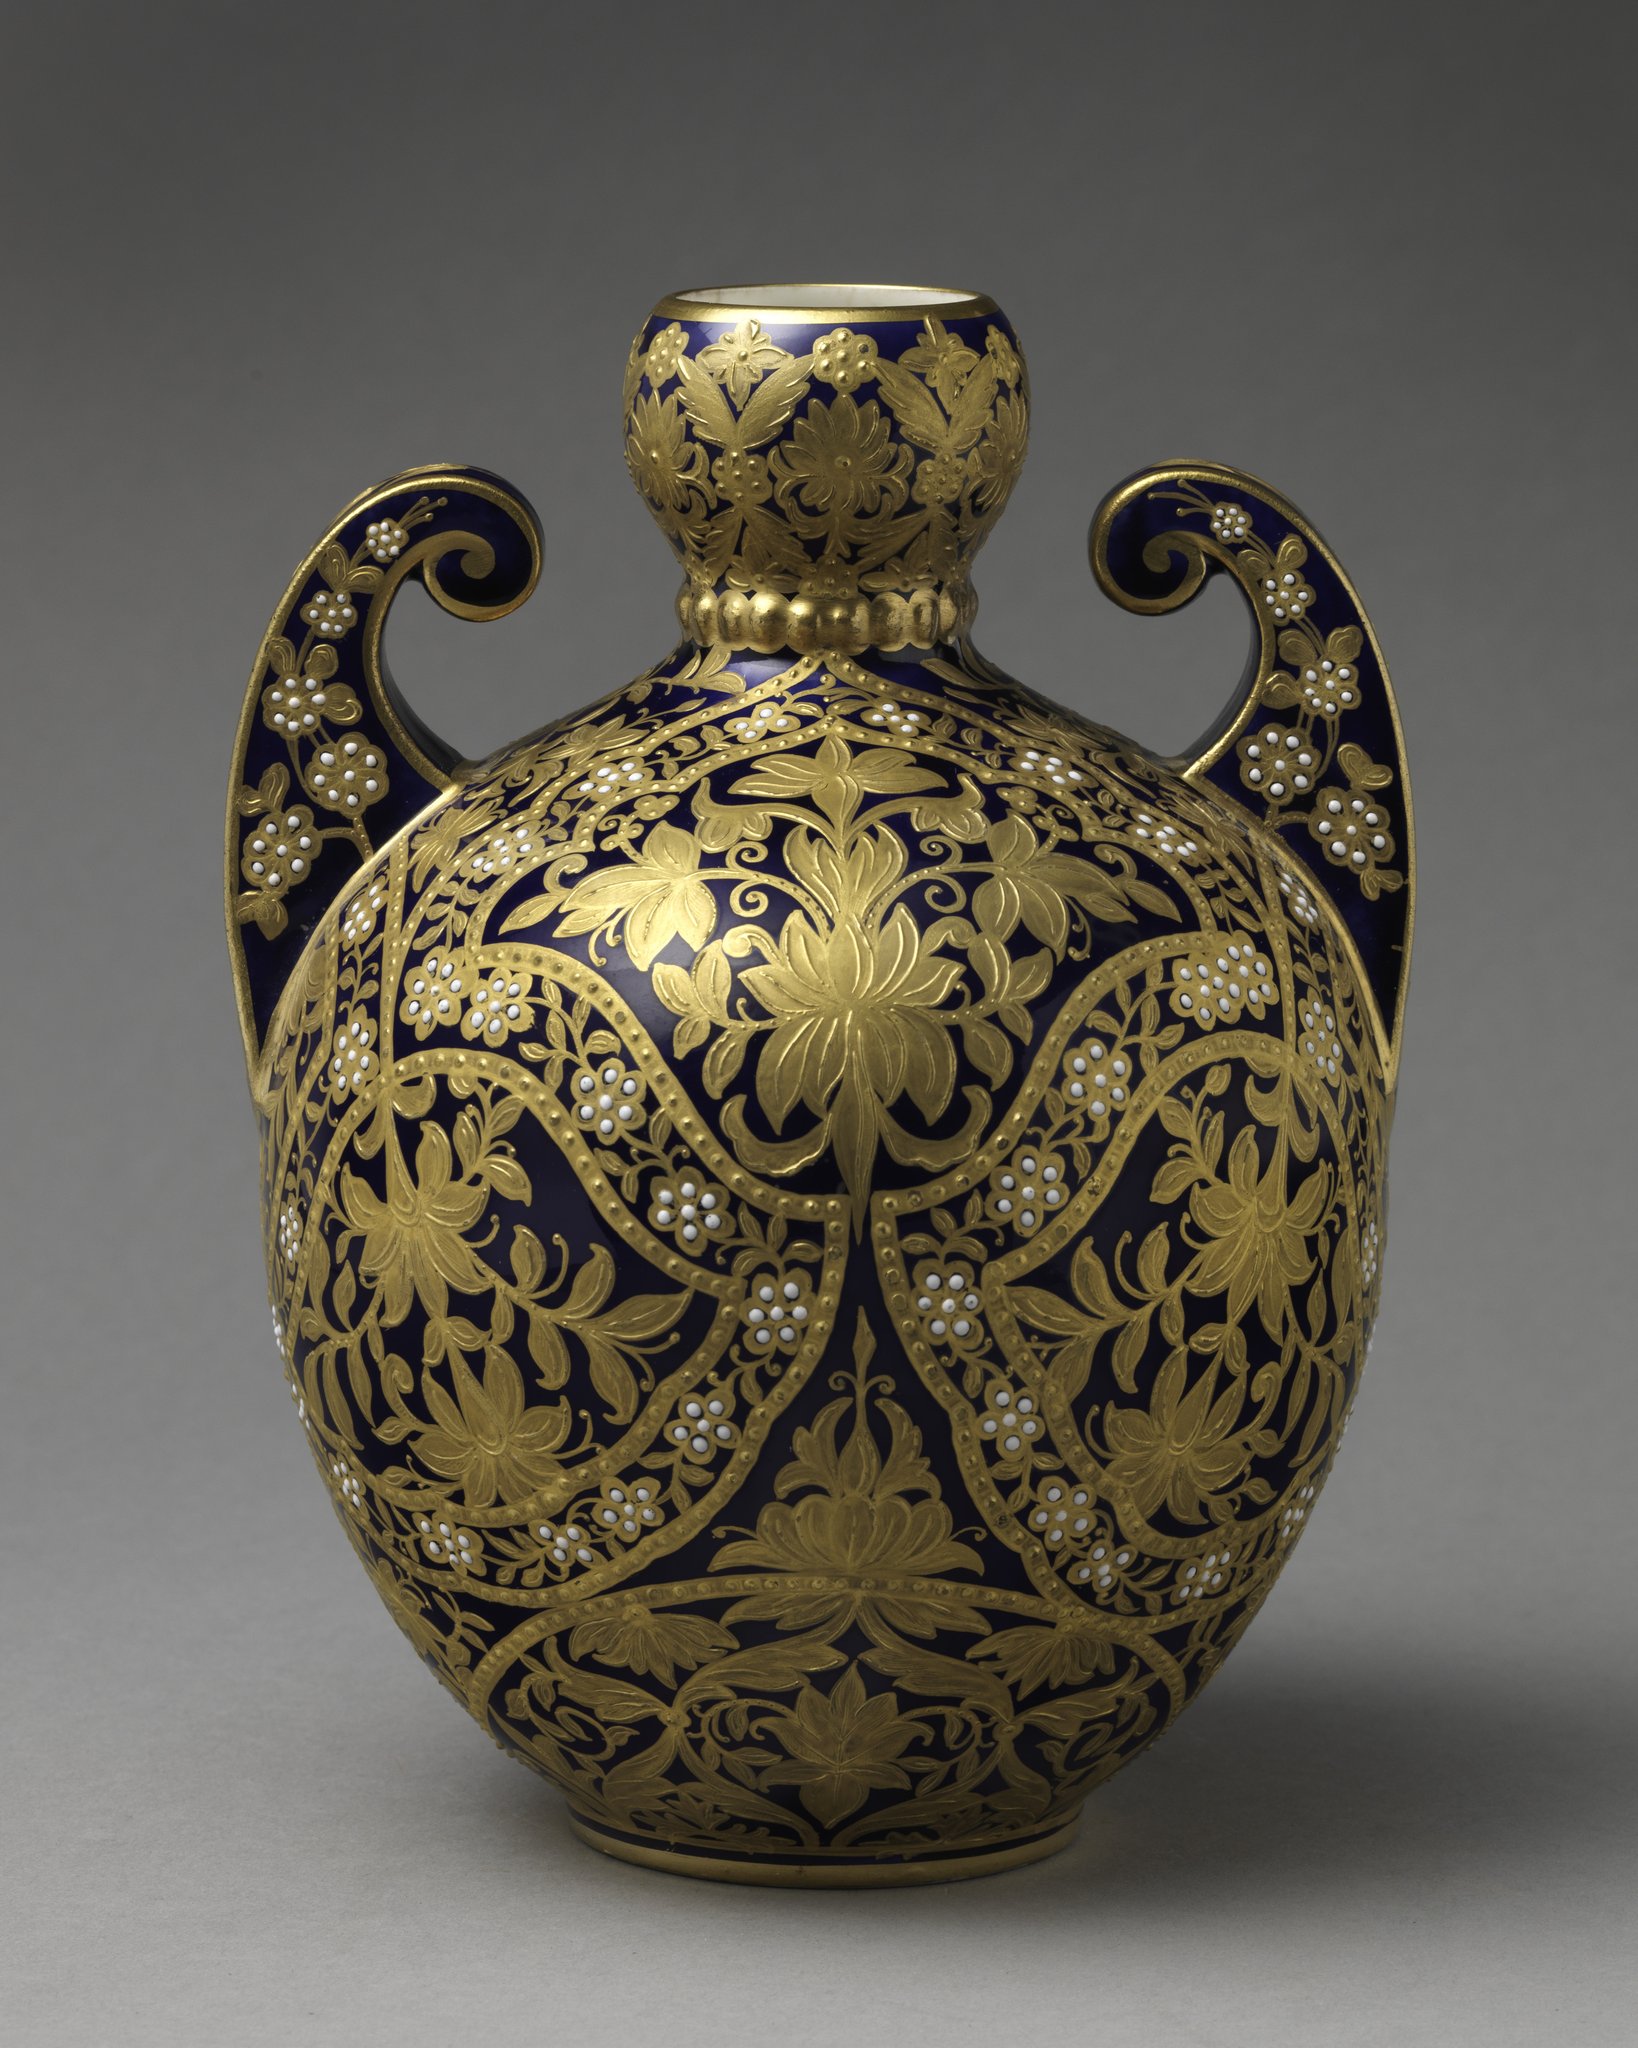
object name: vase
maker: crown derby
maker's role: maker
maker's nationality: british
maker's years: 1750-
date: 1886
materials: porcelain